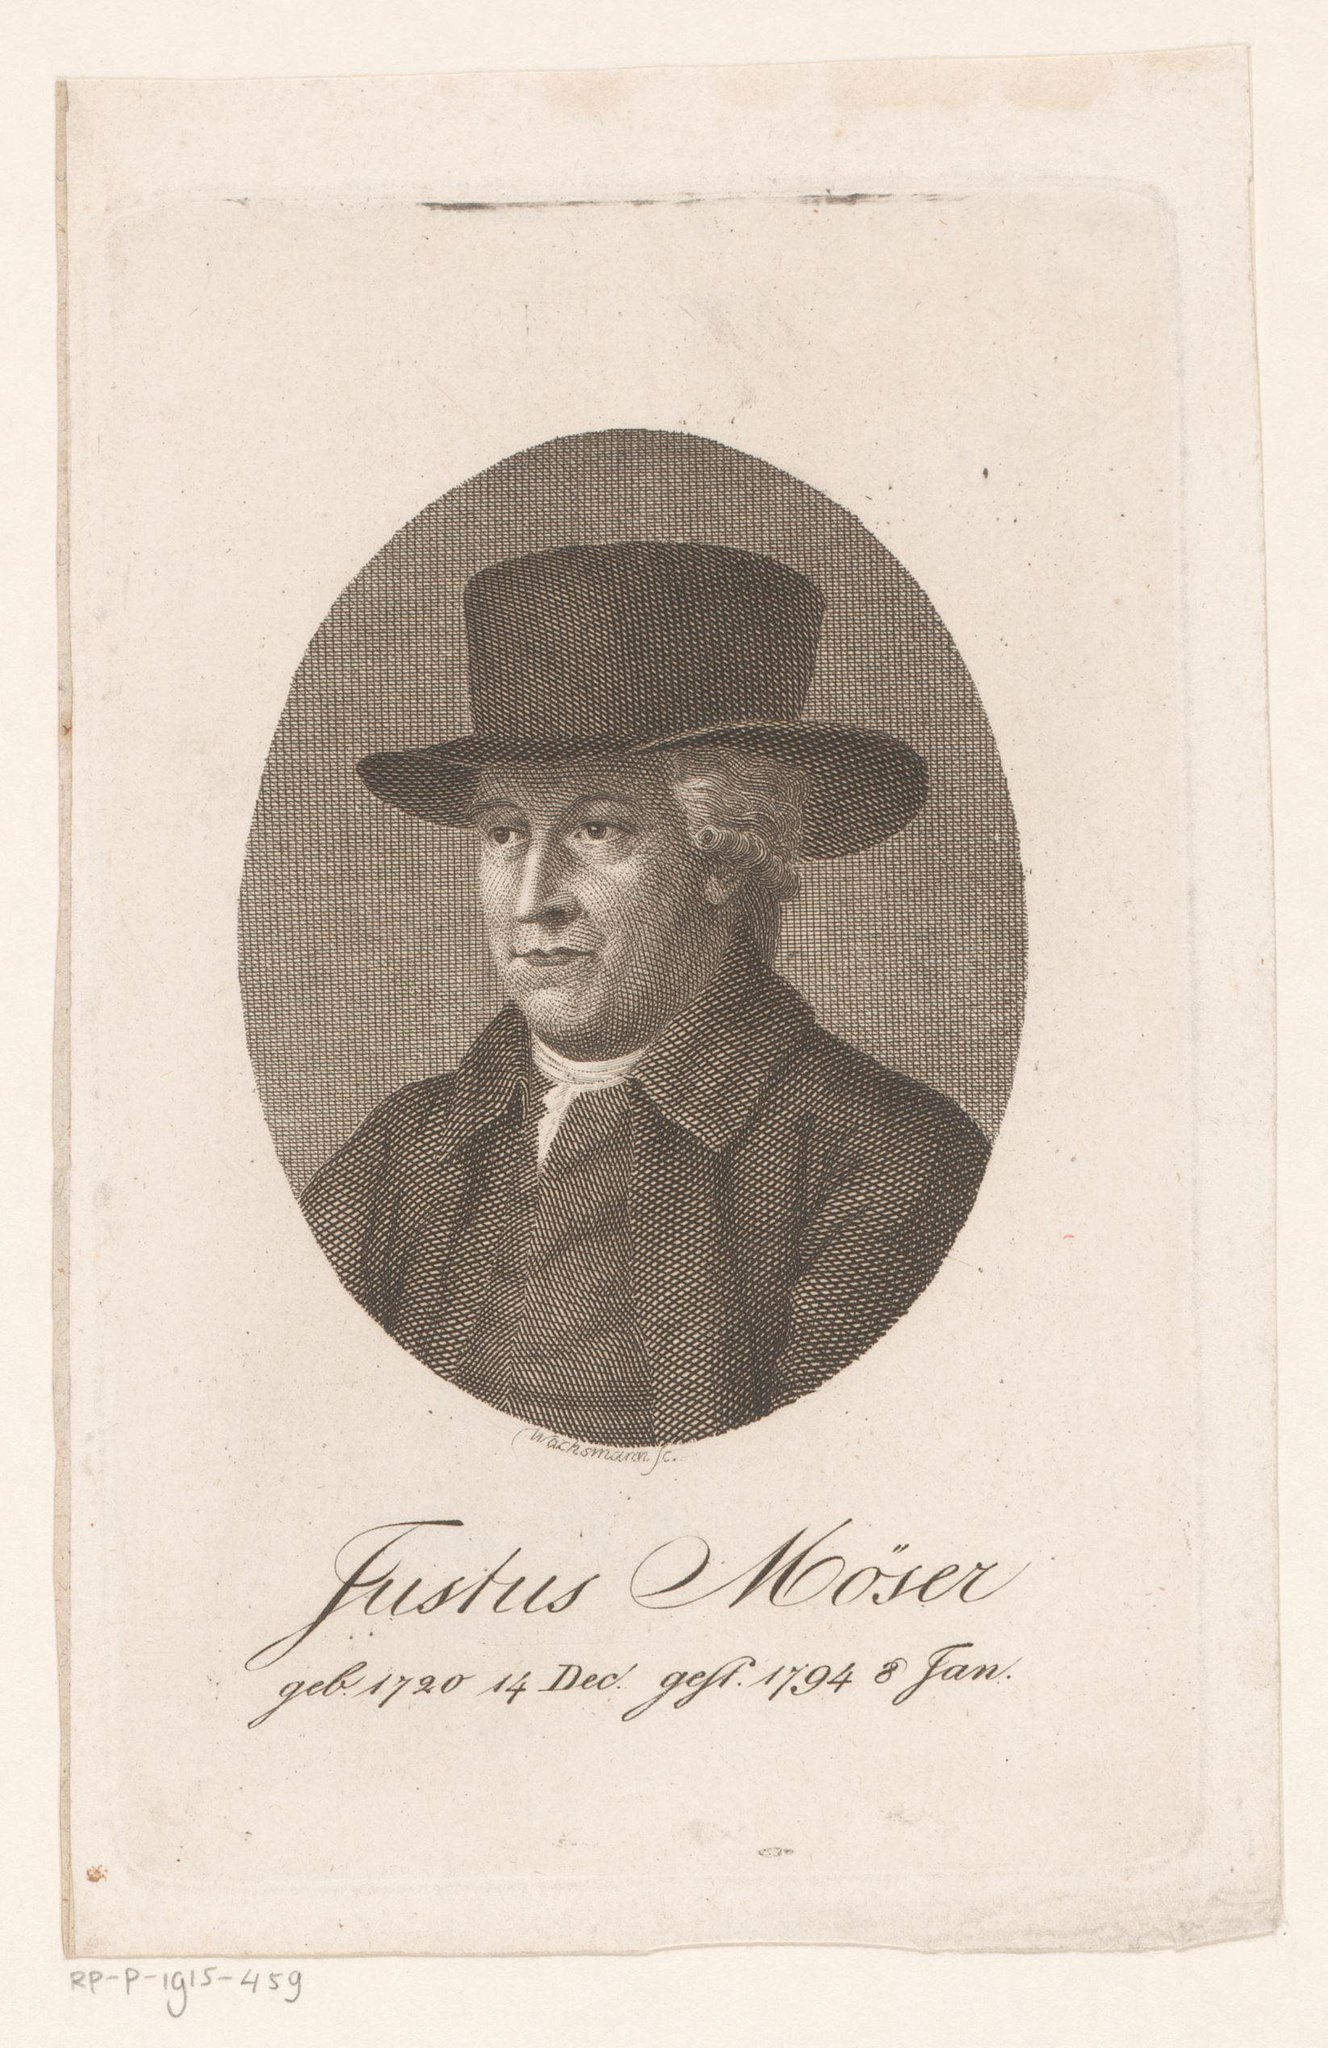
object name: print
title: Portretten van beroemde mensen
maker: anton wachsmann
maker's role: print maker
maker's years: 1765-1836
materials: paper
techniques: engraving, etching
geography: germany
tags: historical persons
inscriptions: collector's mark: Lugt 2228